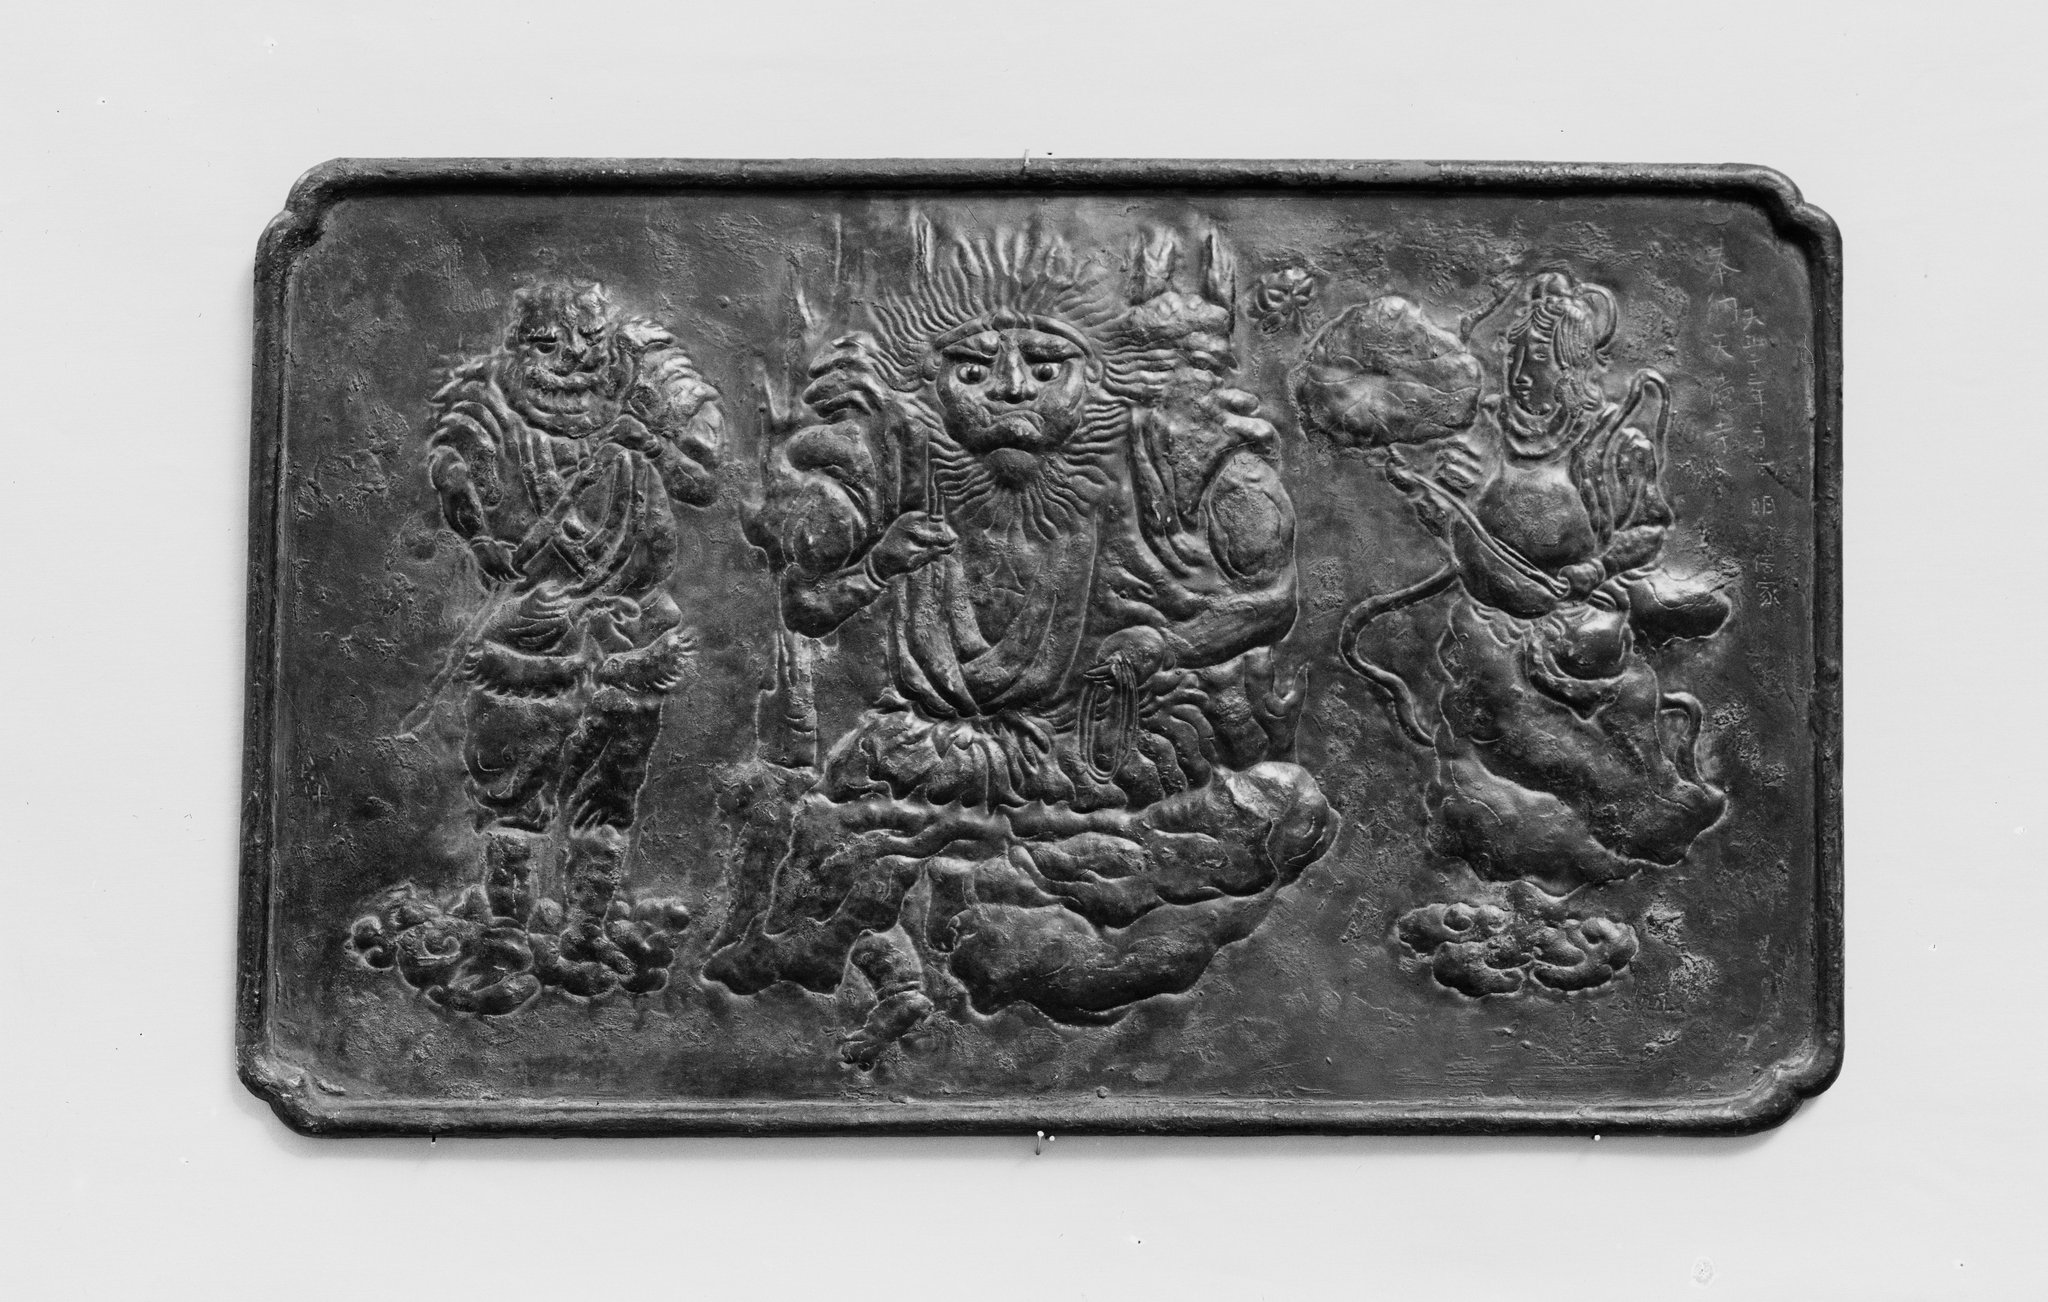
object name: panel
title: Metal plaque with Fudō Myōō and attendants Seitaka Dōji and Kongara Dōji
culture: japanese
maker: myōchin nobuie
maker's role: artist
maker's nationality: japanese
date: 1501-1600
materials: iron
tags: mythical creatures